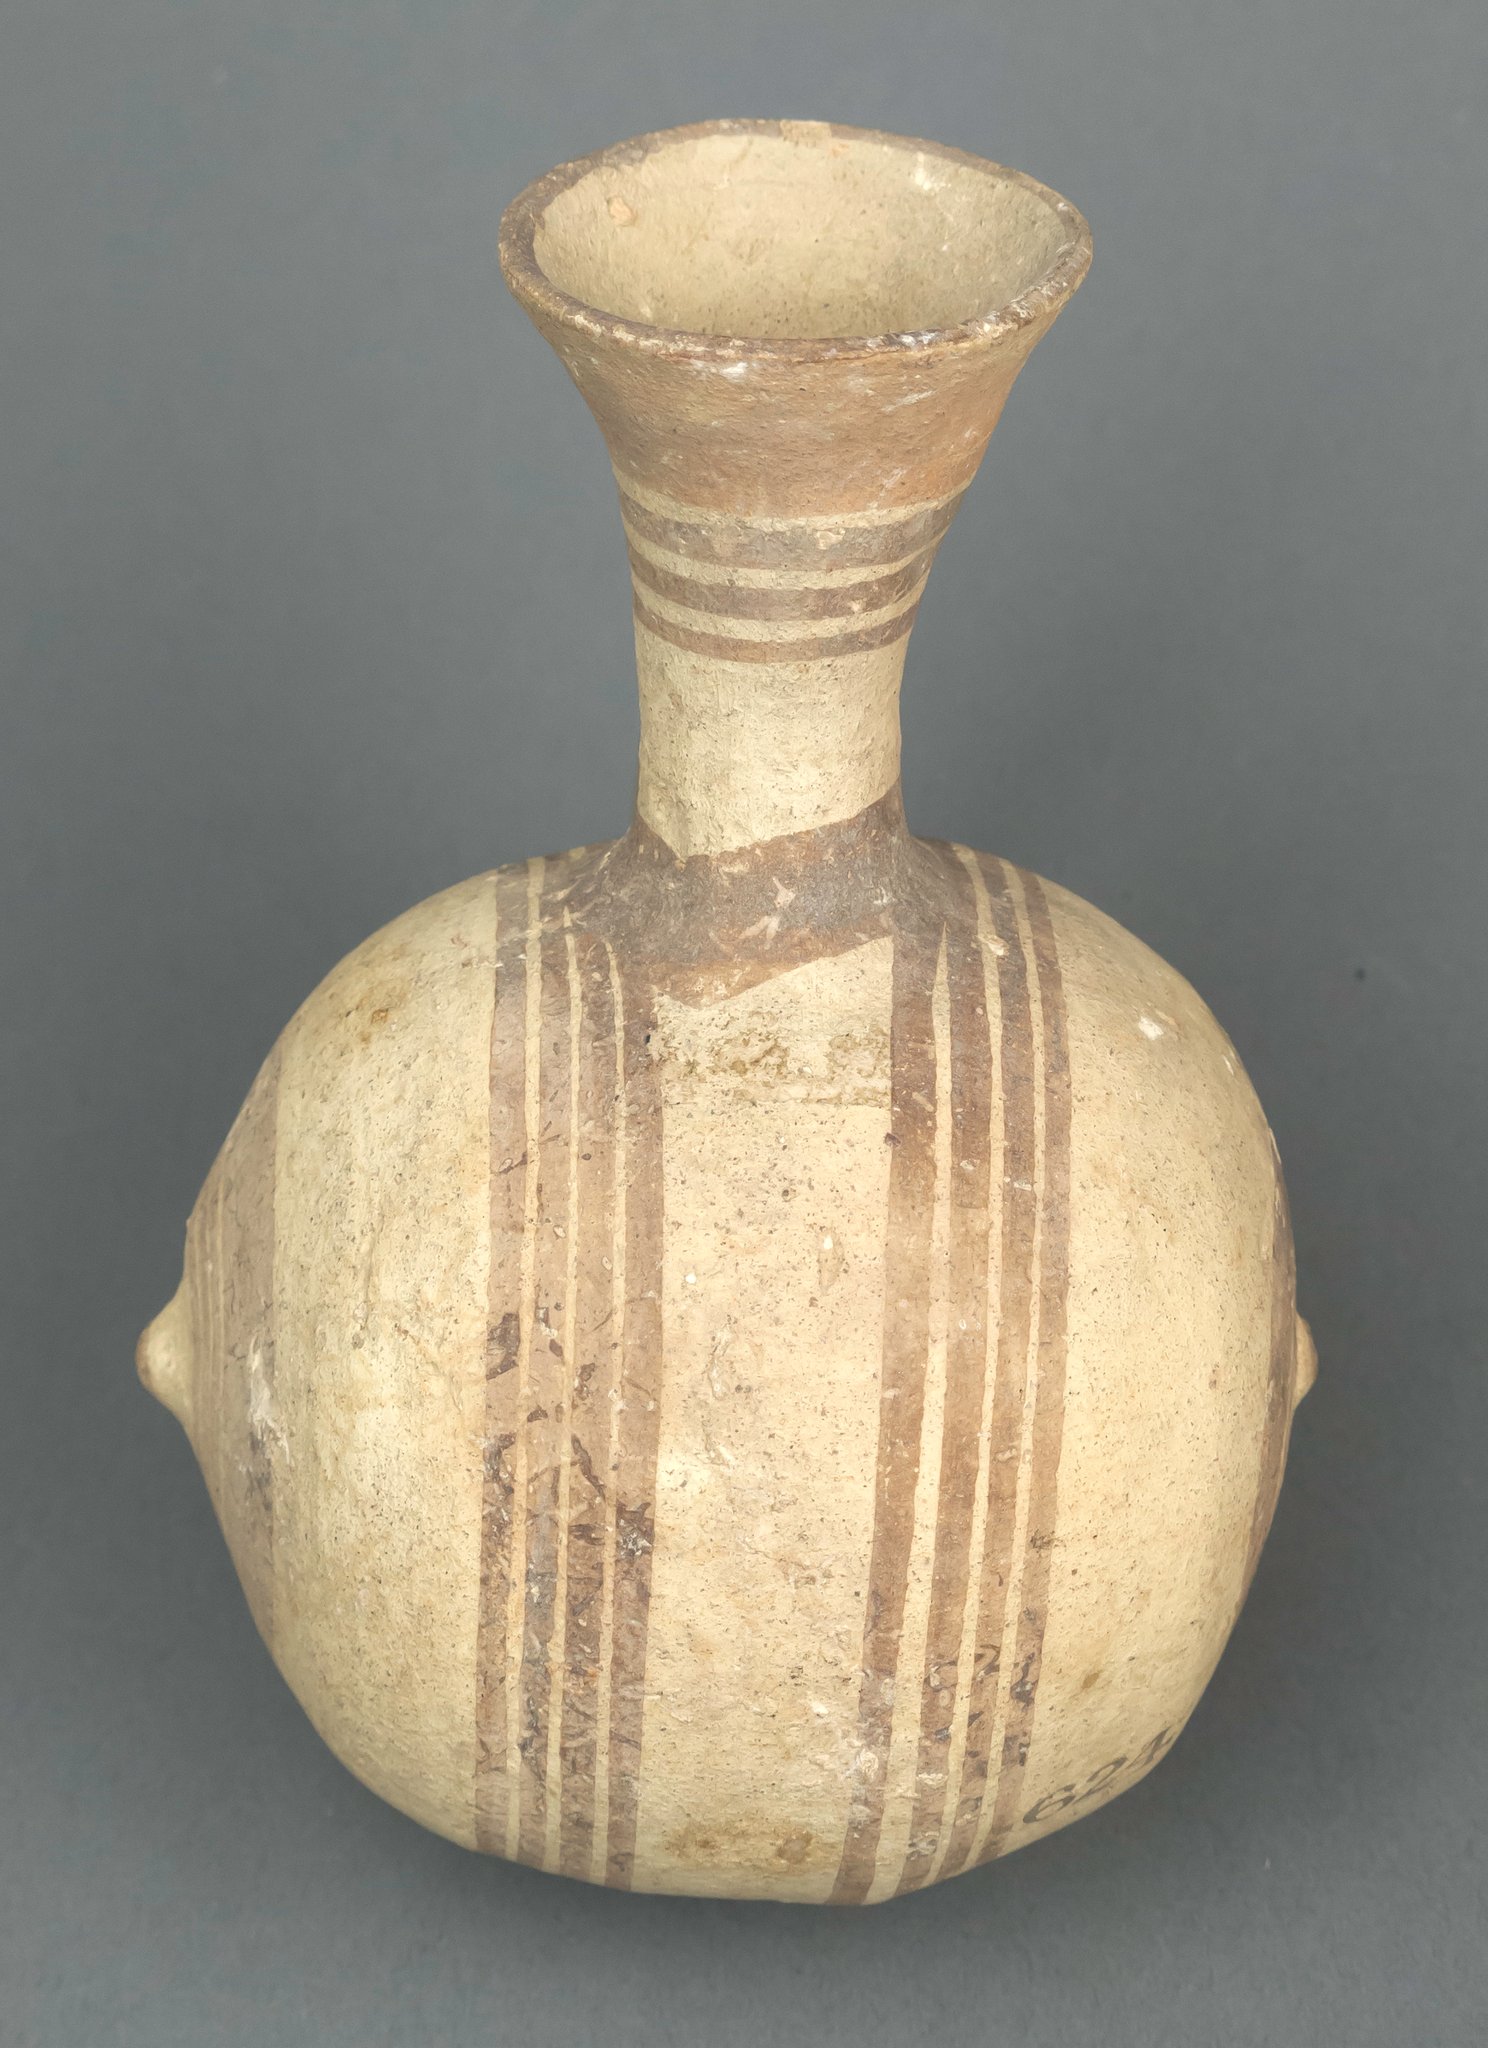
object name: jug, barrel shaped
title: Jug, barrel-shaped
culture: cypriot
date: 850-750 BCE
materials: terracotta